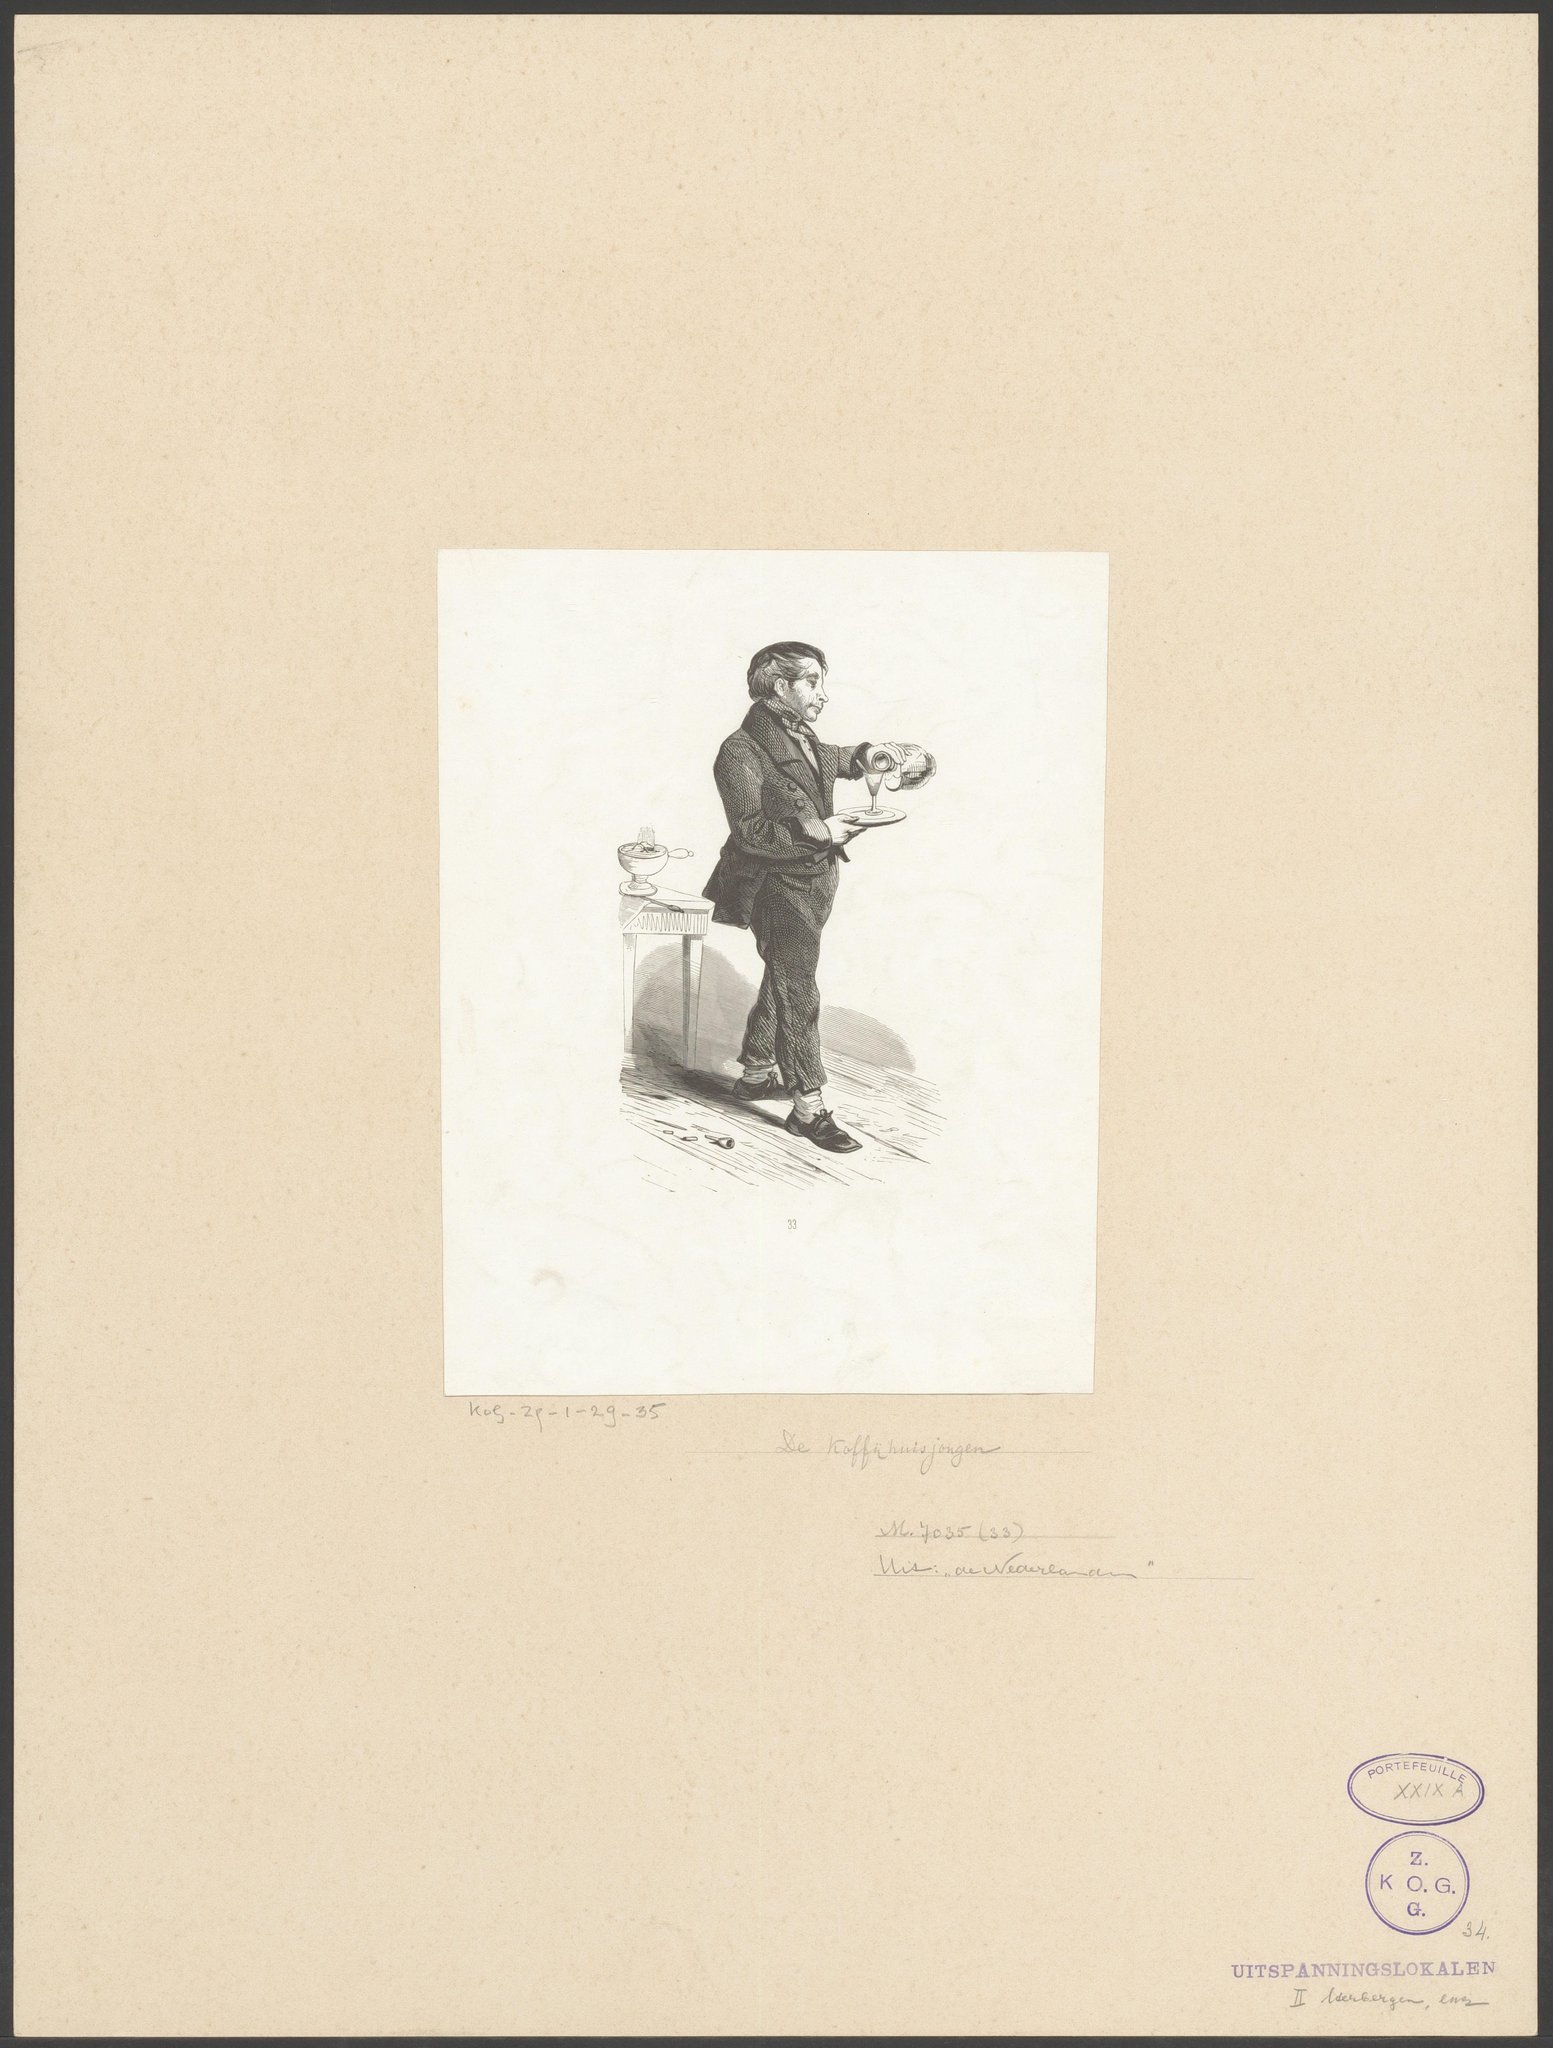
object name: print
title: Koffiehuisjongen, 1840-1841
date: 1841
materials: paper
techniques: engraving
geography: the hague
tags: professional clothes, inn, coffee-house, public house, etc.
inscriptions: stamp, stamp, collector's mark: Lugt 1641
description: Een bediende in een koffiehuis. Staande jongen schenkt een glas in. Genummerd: 33. Uit een boek met karakterschetsen, beroepen en klederdrachten van Nederlandse volkstypen uit 1841. Onderwerpsrubrieken binnen de Atlas Zeden en Gewoonten: Zeden en gewoonten in engeren zin, Volksleven, Uitspanningslokalen, Koffiehuizen.